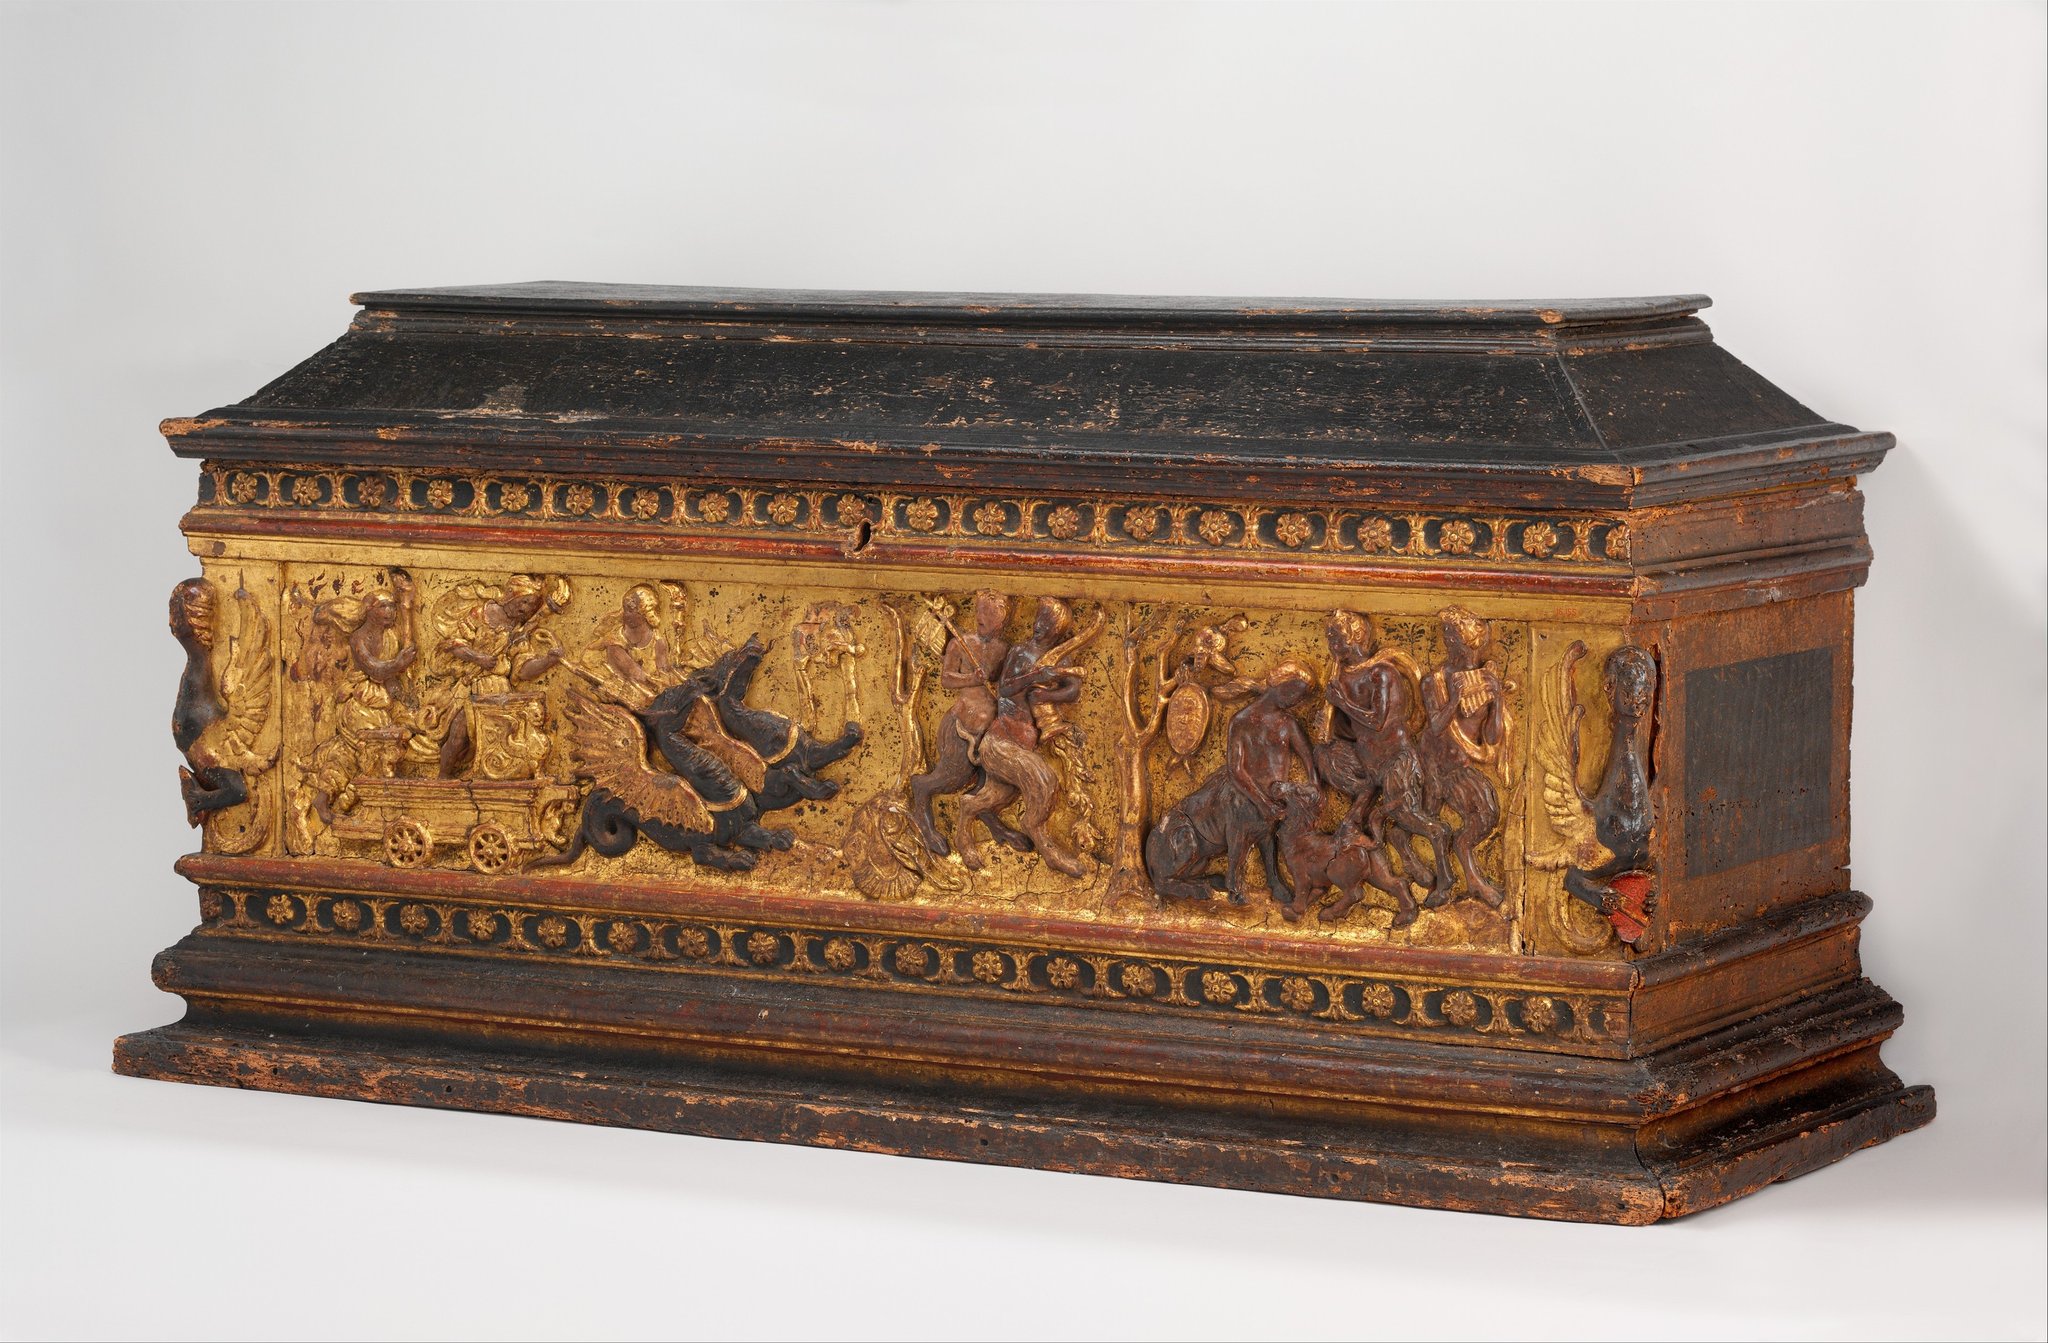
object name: marriage chest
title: Marriage chest (cassone)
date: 1480-1495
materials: gesso, wood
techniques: gilding, painting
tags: centaurs,dragons,satyrs,chariots